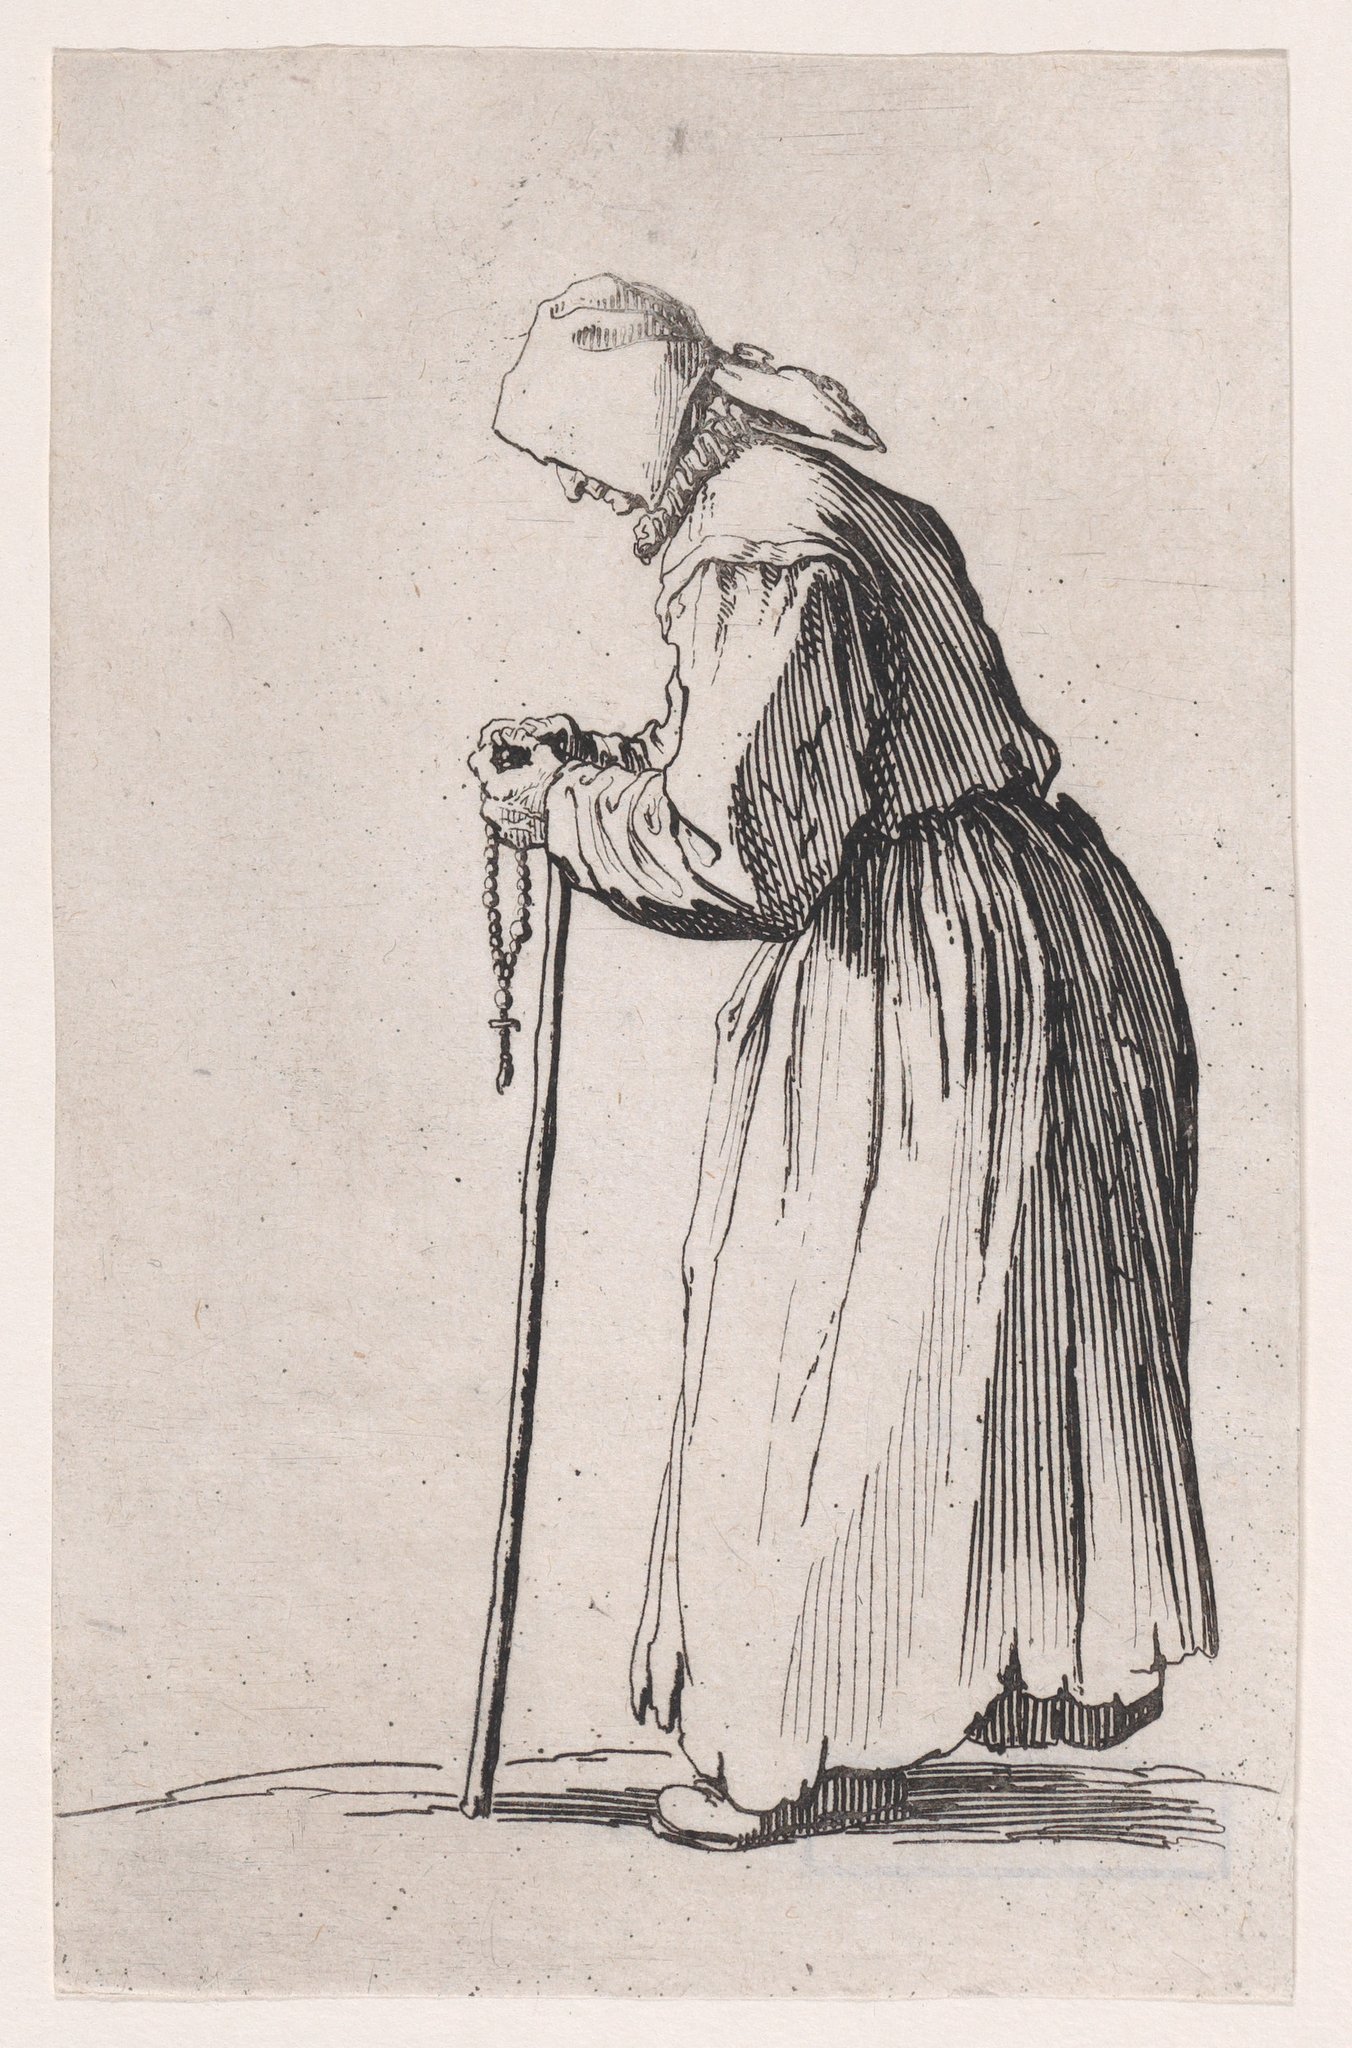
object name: print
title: La Mendiante au Rosaire (The Beggar with a Rosary), from "Les Gueux suite appelée aussi Les Mendiants, Les Baroni, ou Les Barons" (The Beggars, also called the Barons)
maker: jacques callot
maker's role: artist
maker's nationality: french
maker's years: 1592-1635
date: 1623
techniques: etching